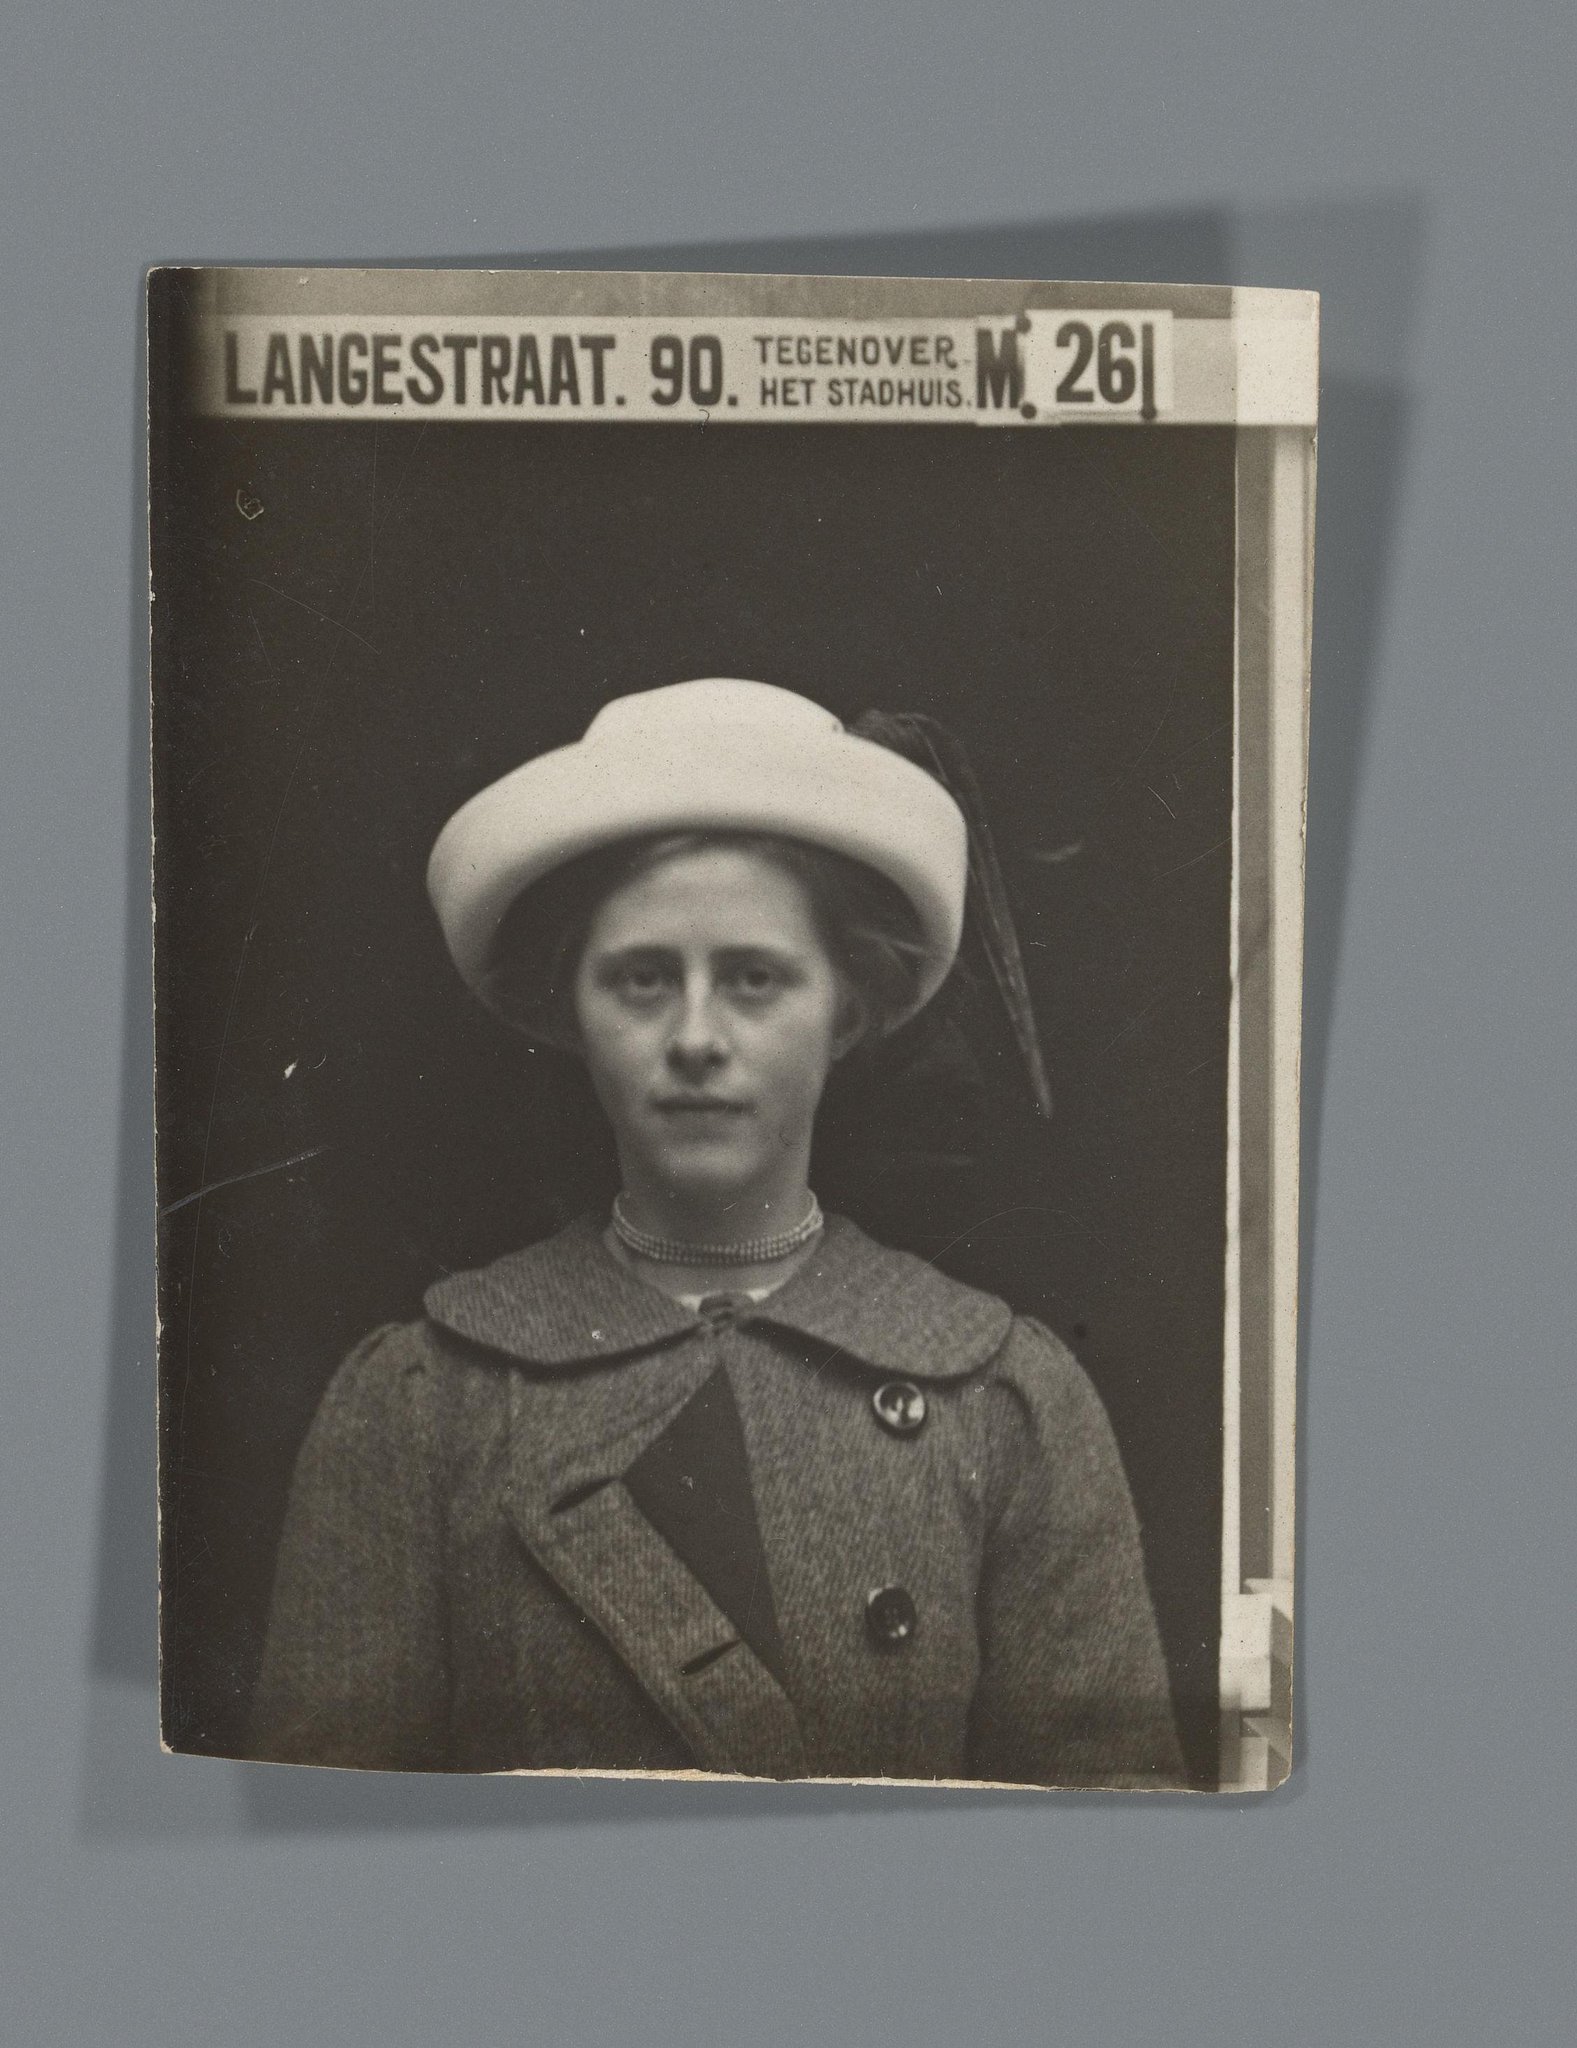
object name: snapshot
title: Rapid photographs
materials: photographic support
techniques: gelatin silver print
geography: alkmaar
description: Between 1912 and 1930, anyone could have their portrait taken at the many so-called rapid photography studios in the shopping streets of mainly (medium) large-size European cities. As if on an assembly line, the youngest clerk shot the photographs with a special camera and in artificial light and developed them. Later in the day, the customer collected a sheet with 12 portrait photos for 25 cents. This form of photographic mass production gave rise to a fascinating tableau of boys, girls, men and women not previously seen in photographs; candid and informal. There were at least 150 quick-photo studios, from Alkmaar to Zutphen. Many called themselves ‘American,’ mistakenly as it turns out because hardly any examples from that country have been found.